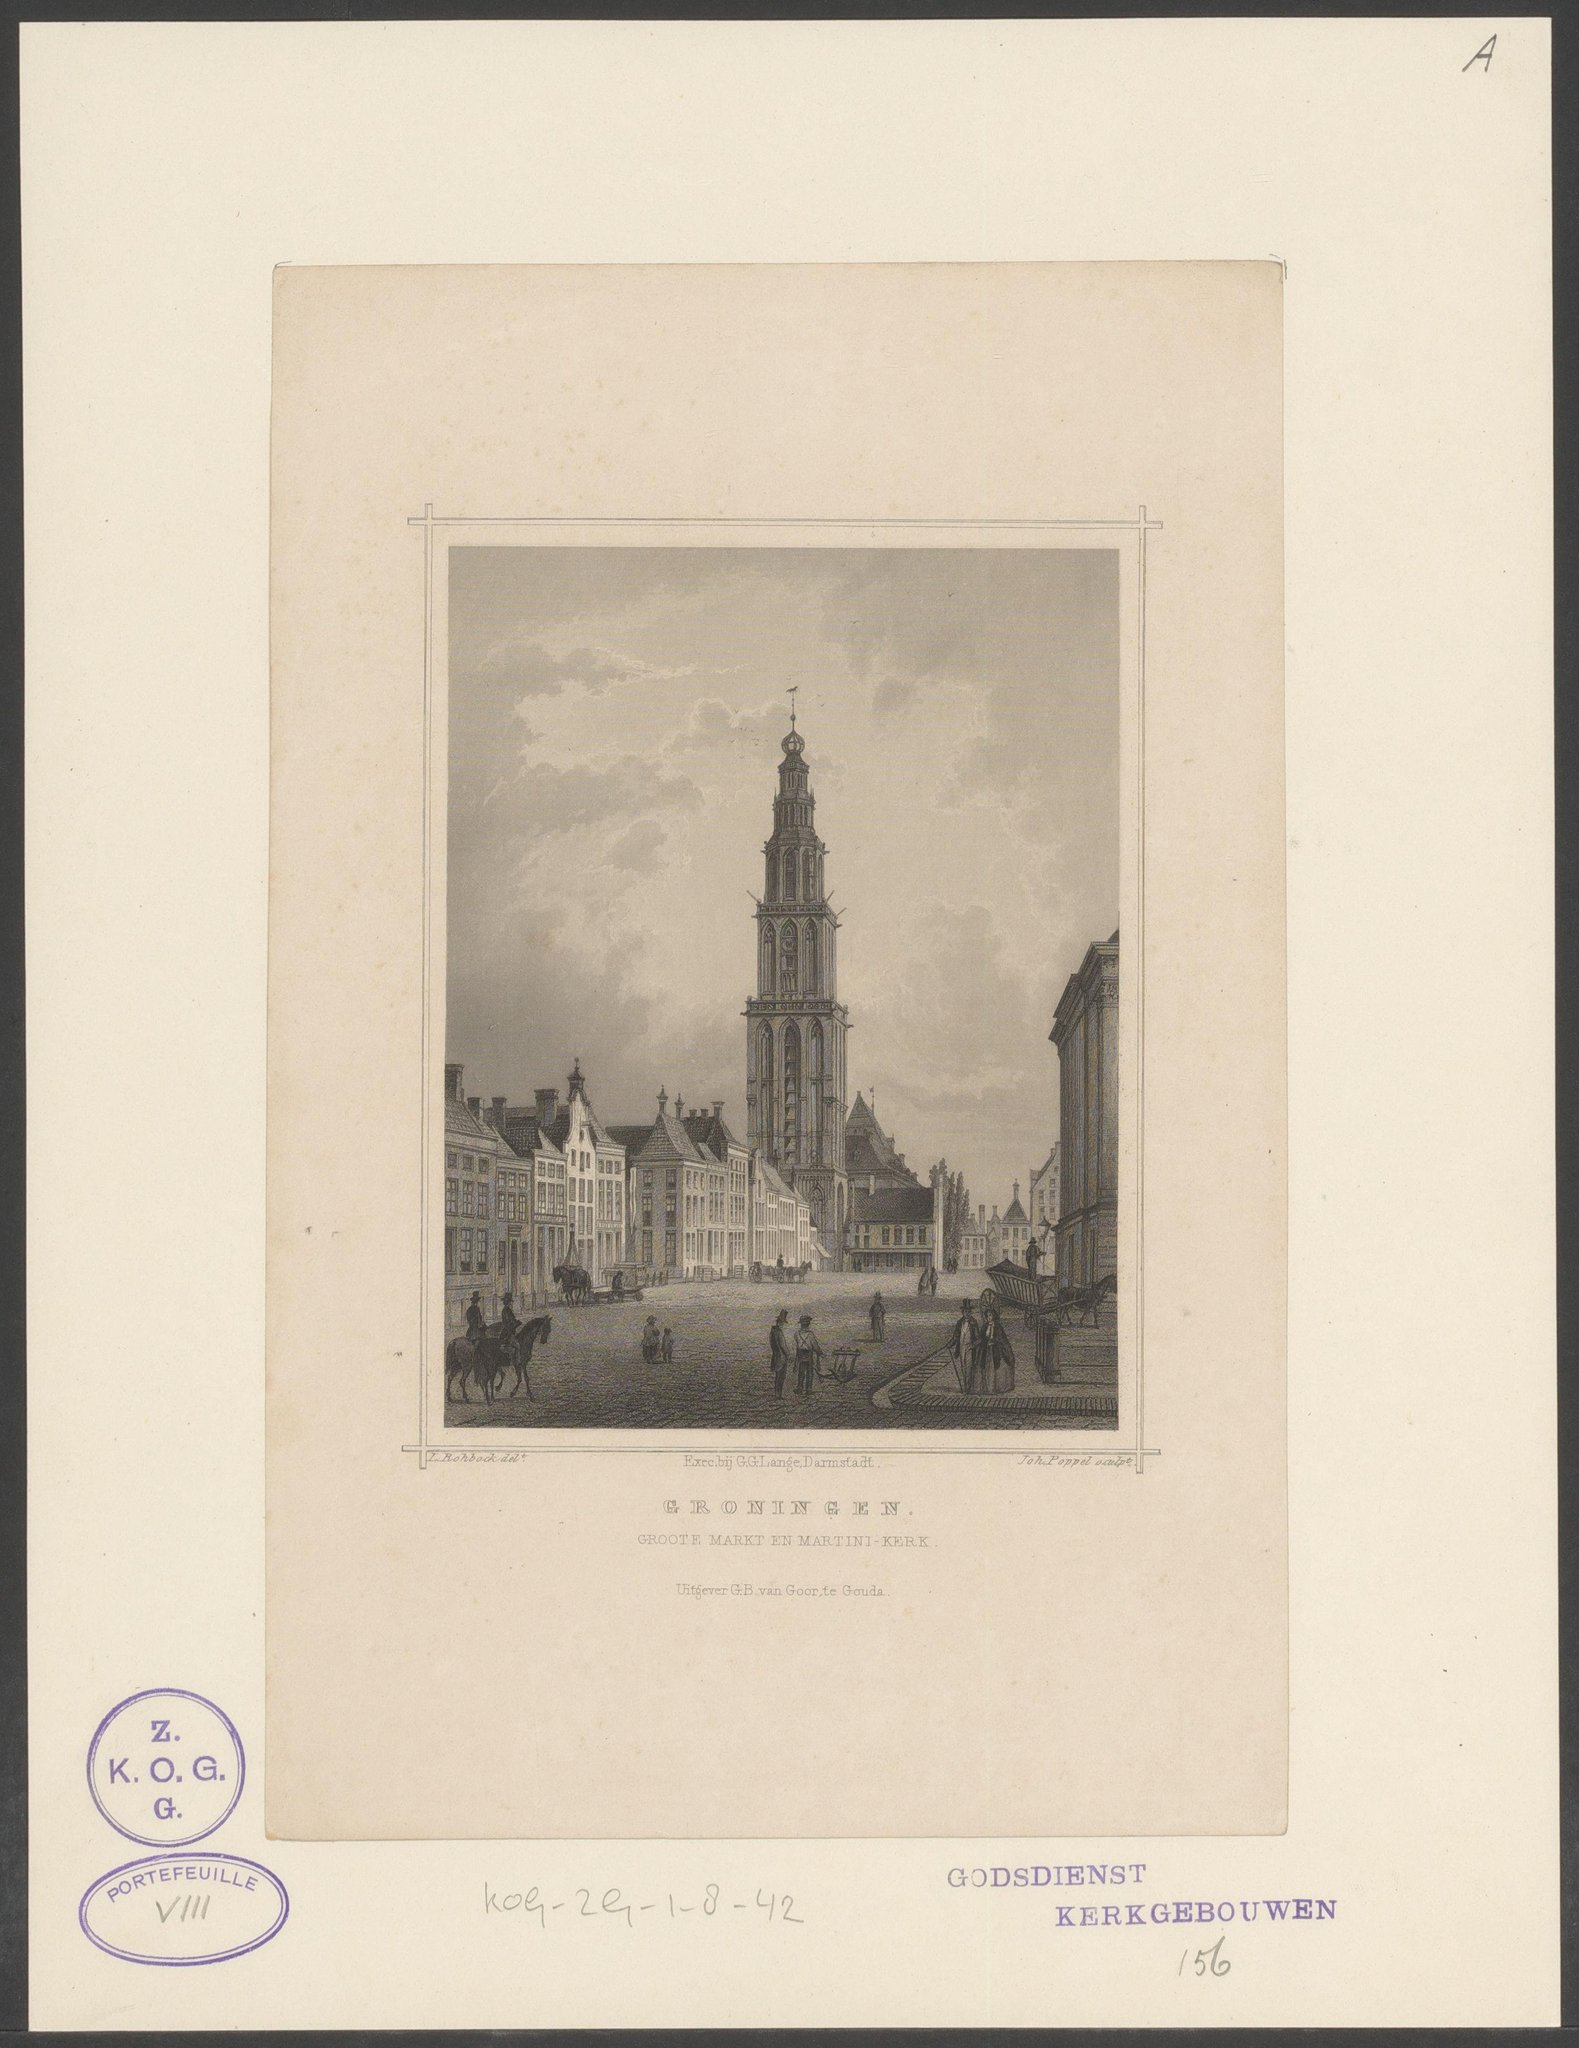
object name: print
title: Groningen. Groote Markt en Martini-Kerk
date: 1855-1857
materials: paper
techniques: engraving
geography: gouda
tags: church (exterior)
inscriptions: collector's mark, collector's mark: Lugt 1641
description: Prent uit: Terwen, J.L. Het koningrijk der Nederlanden (...). 2 dln. Gouda: G.B. van Goor, 1857. Dezelfde prent, met een ander onderschrift, komt ook voor in: Der Rhein und die Rheinlande in malerischen Original-ansichten. 3 dln. Darmstadt: G.G. Lange, 1863.